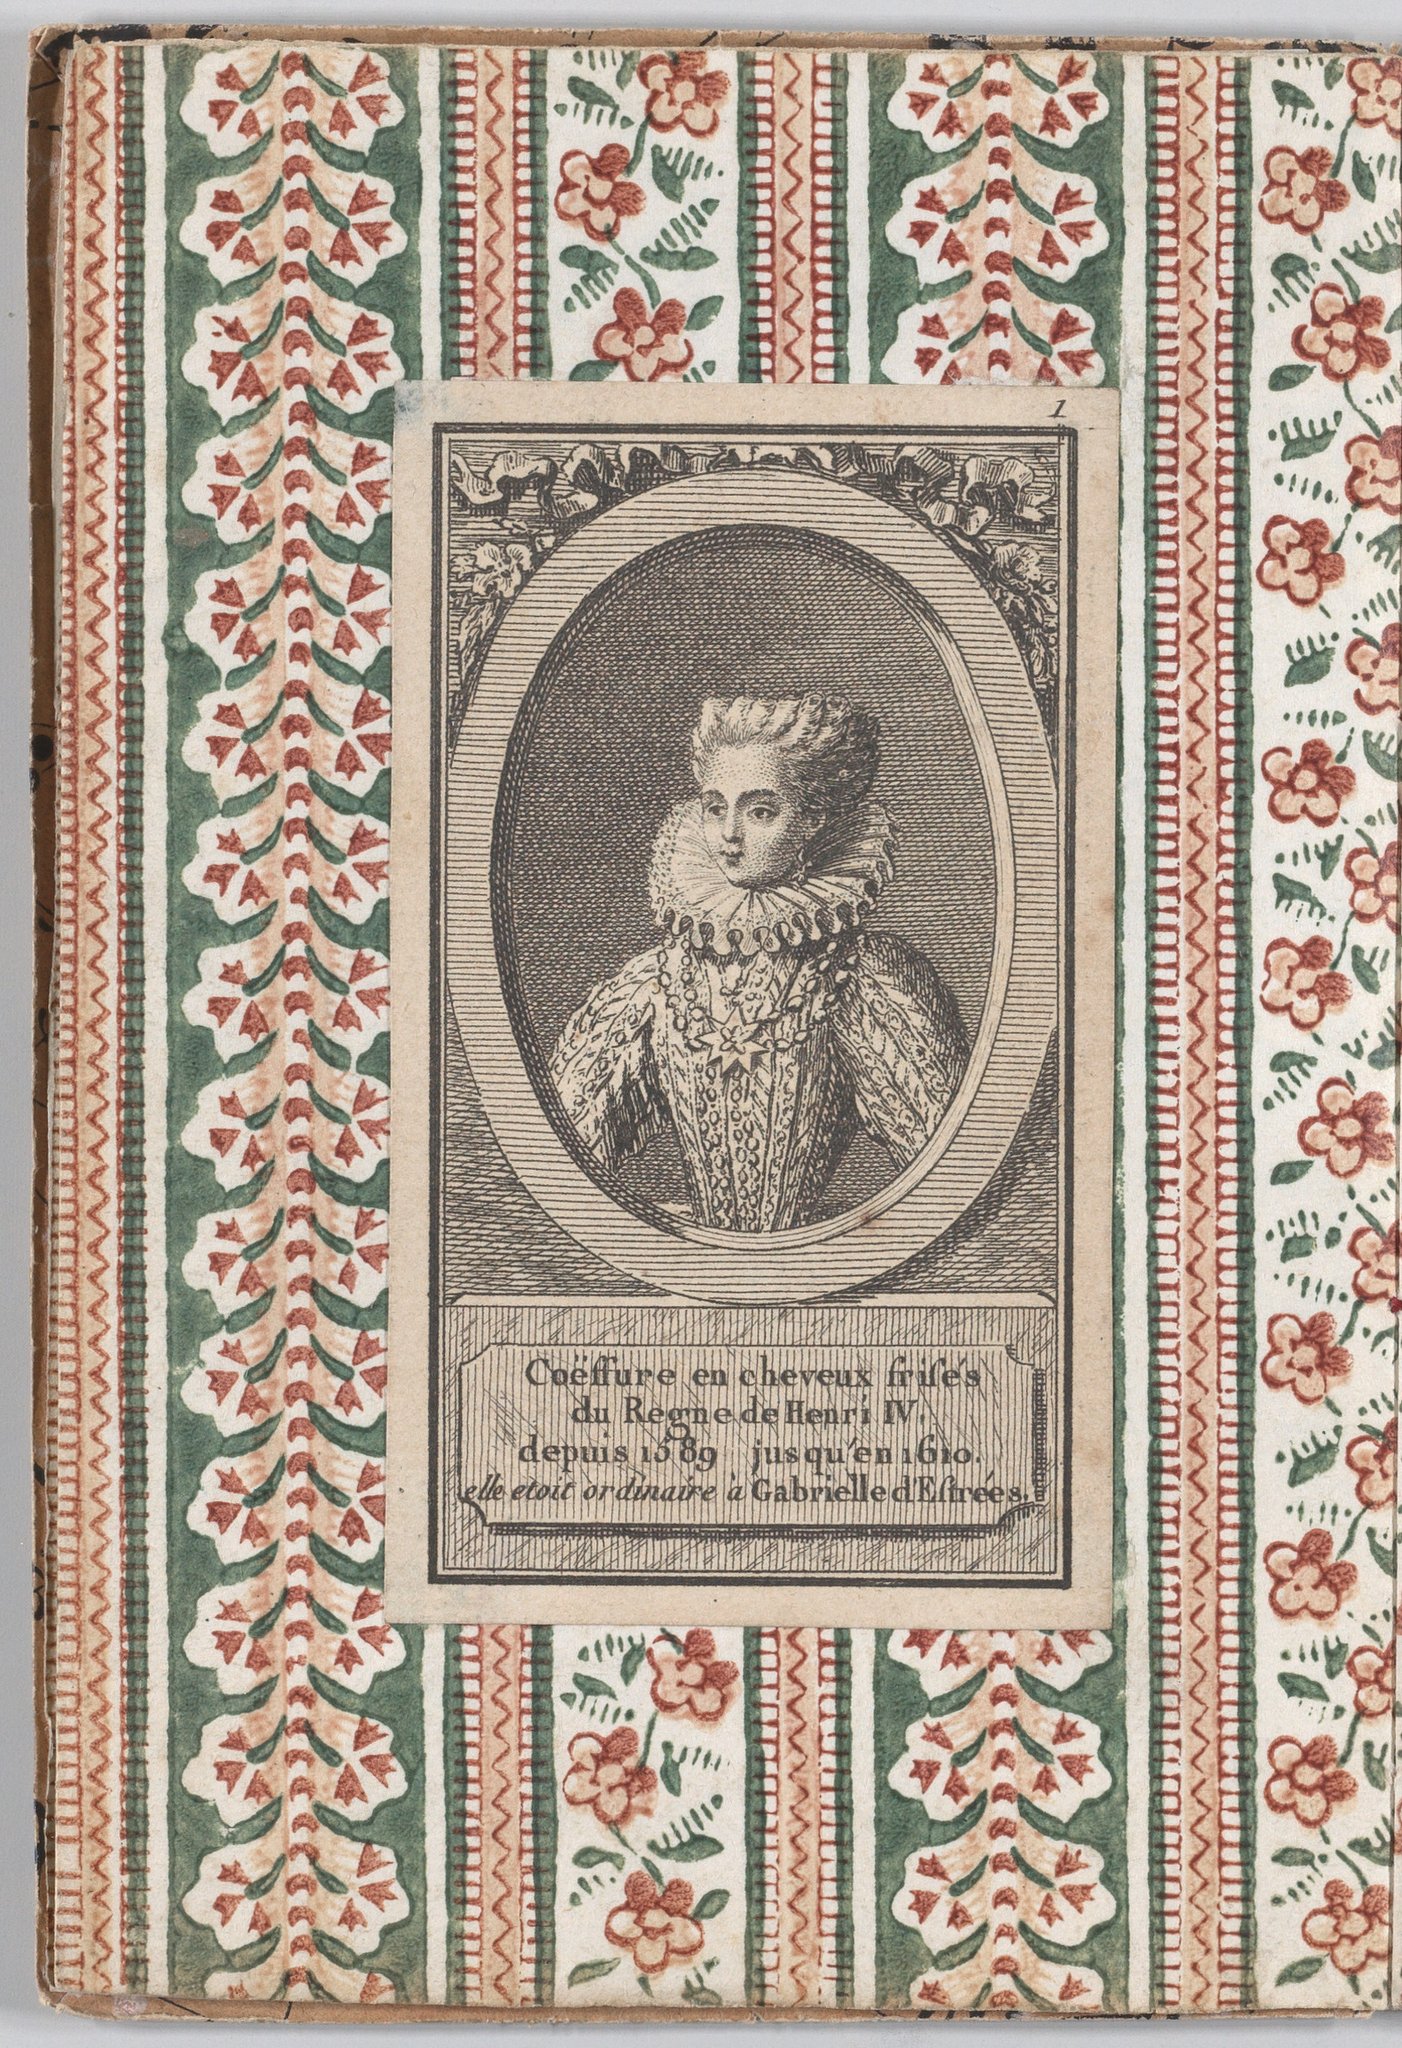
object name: book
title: Twelves Plates from "Almanach de la toilette et de la coiffure des dames françoises"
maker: remondini family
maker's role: artist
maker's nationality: italian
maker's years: 1649-1861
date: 1779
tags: women